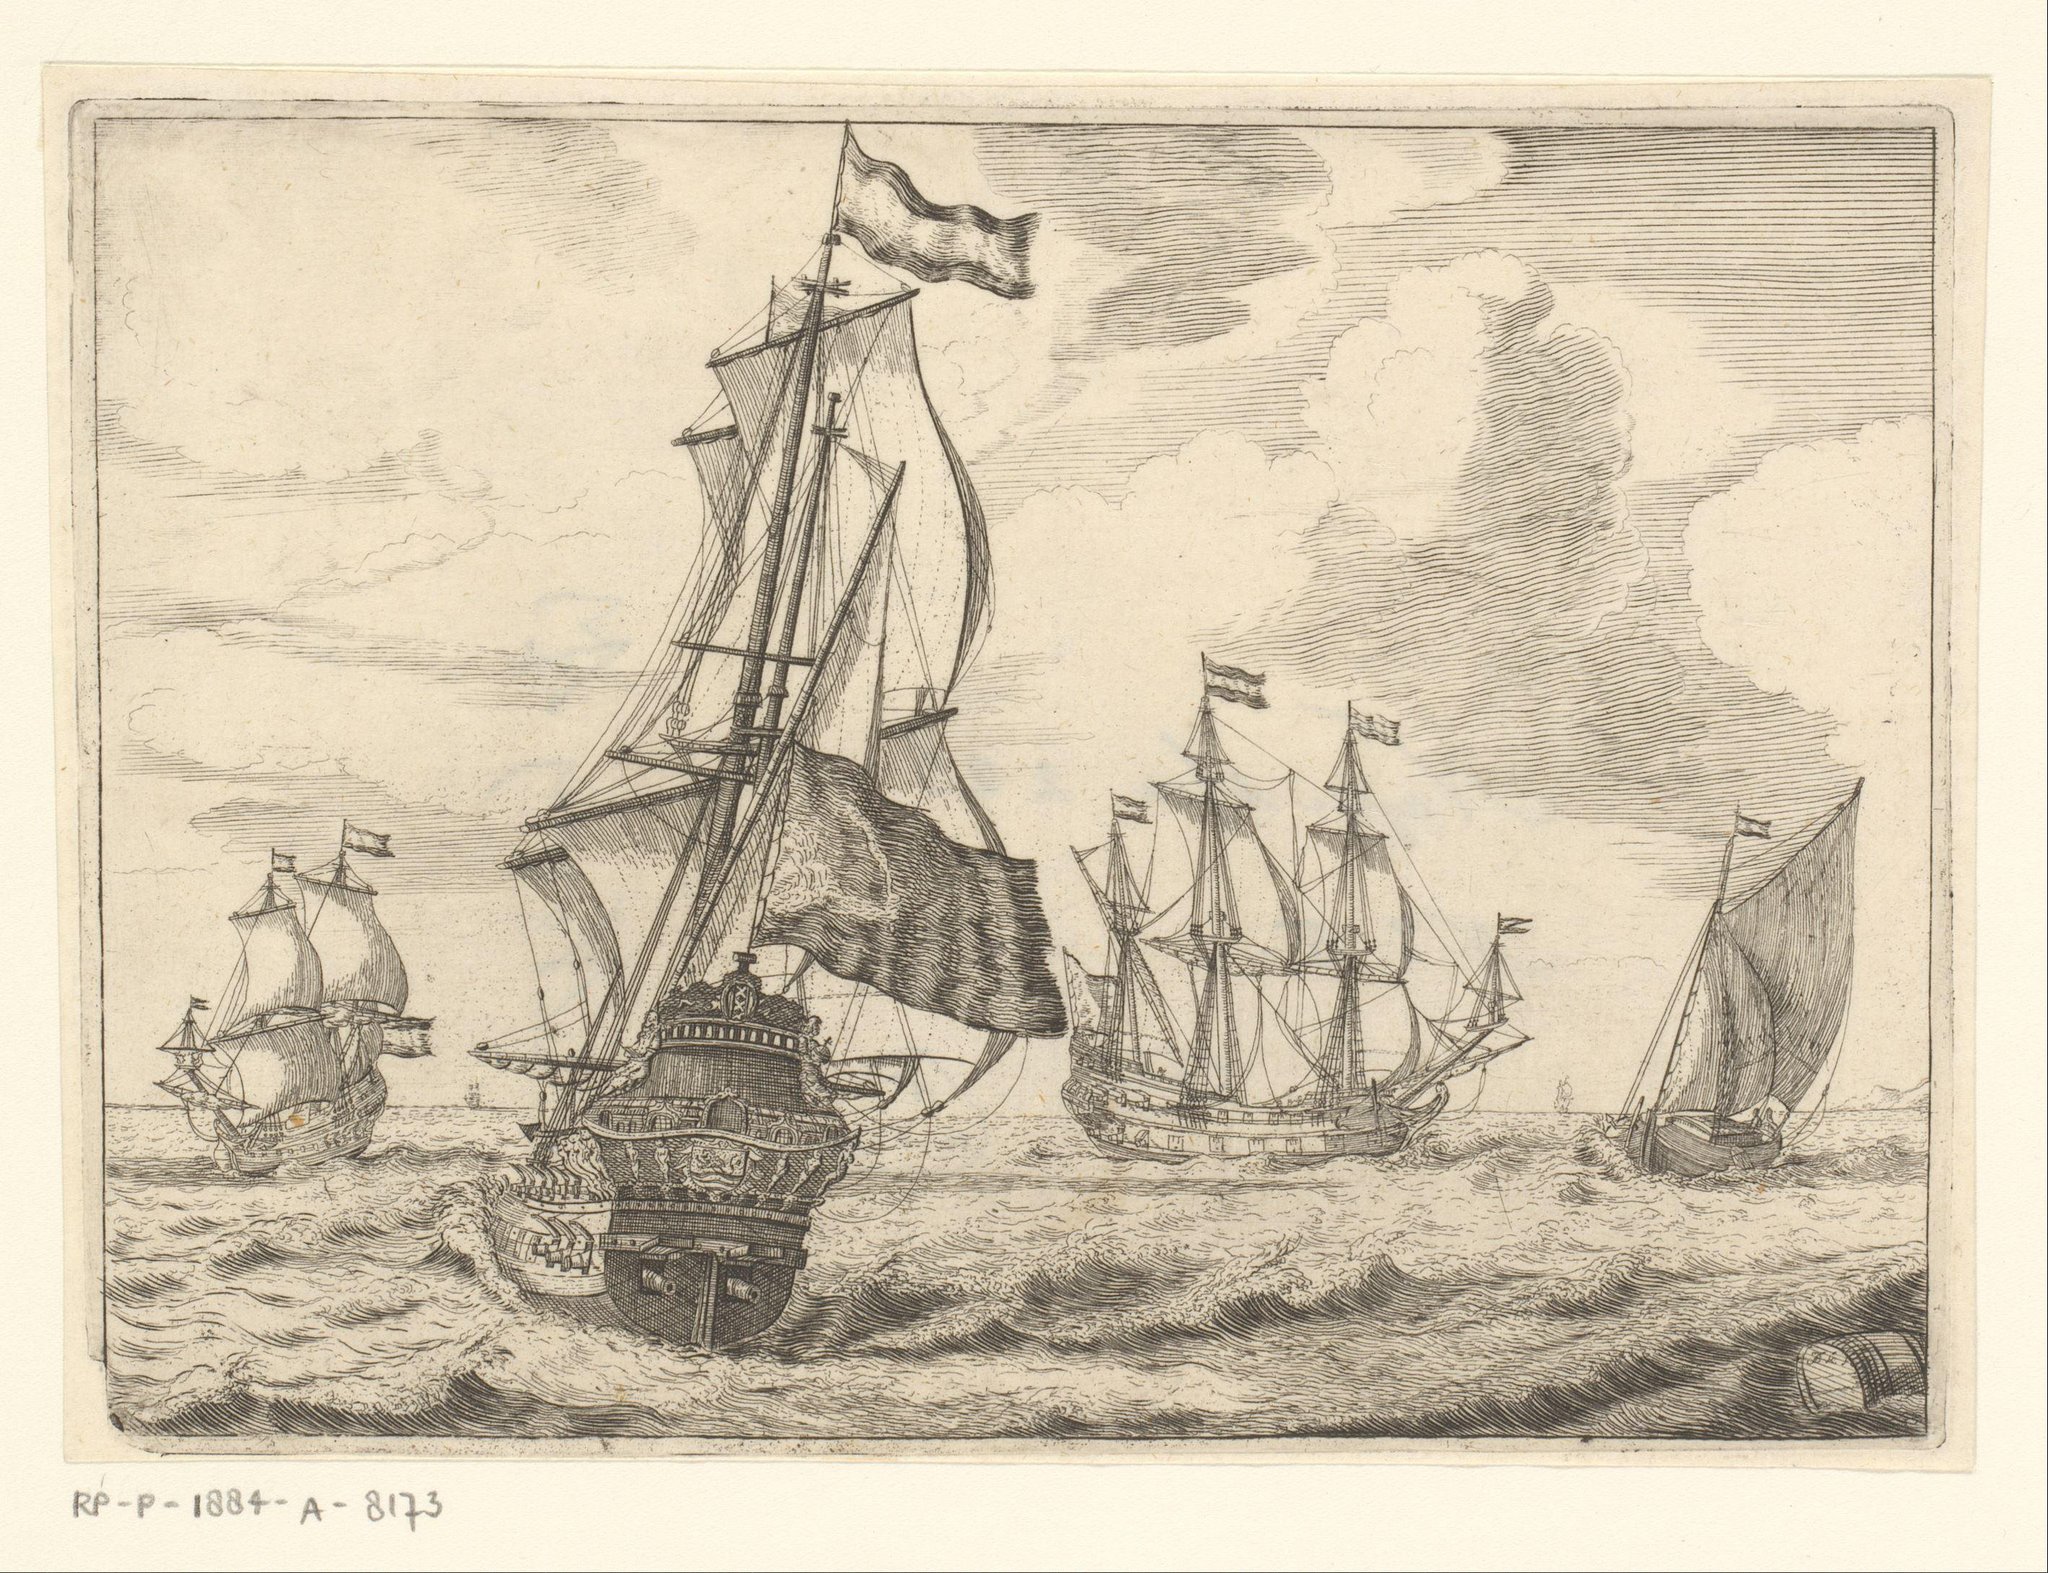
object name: print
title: Oorlogsschepen op een woelige zee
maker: monogrammist abk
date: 1640-1660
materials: paper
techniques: etching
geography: northern netherlands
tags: sailing-ship, sailing-boat, sea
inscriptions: collector's mark: Lugt 2228